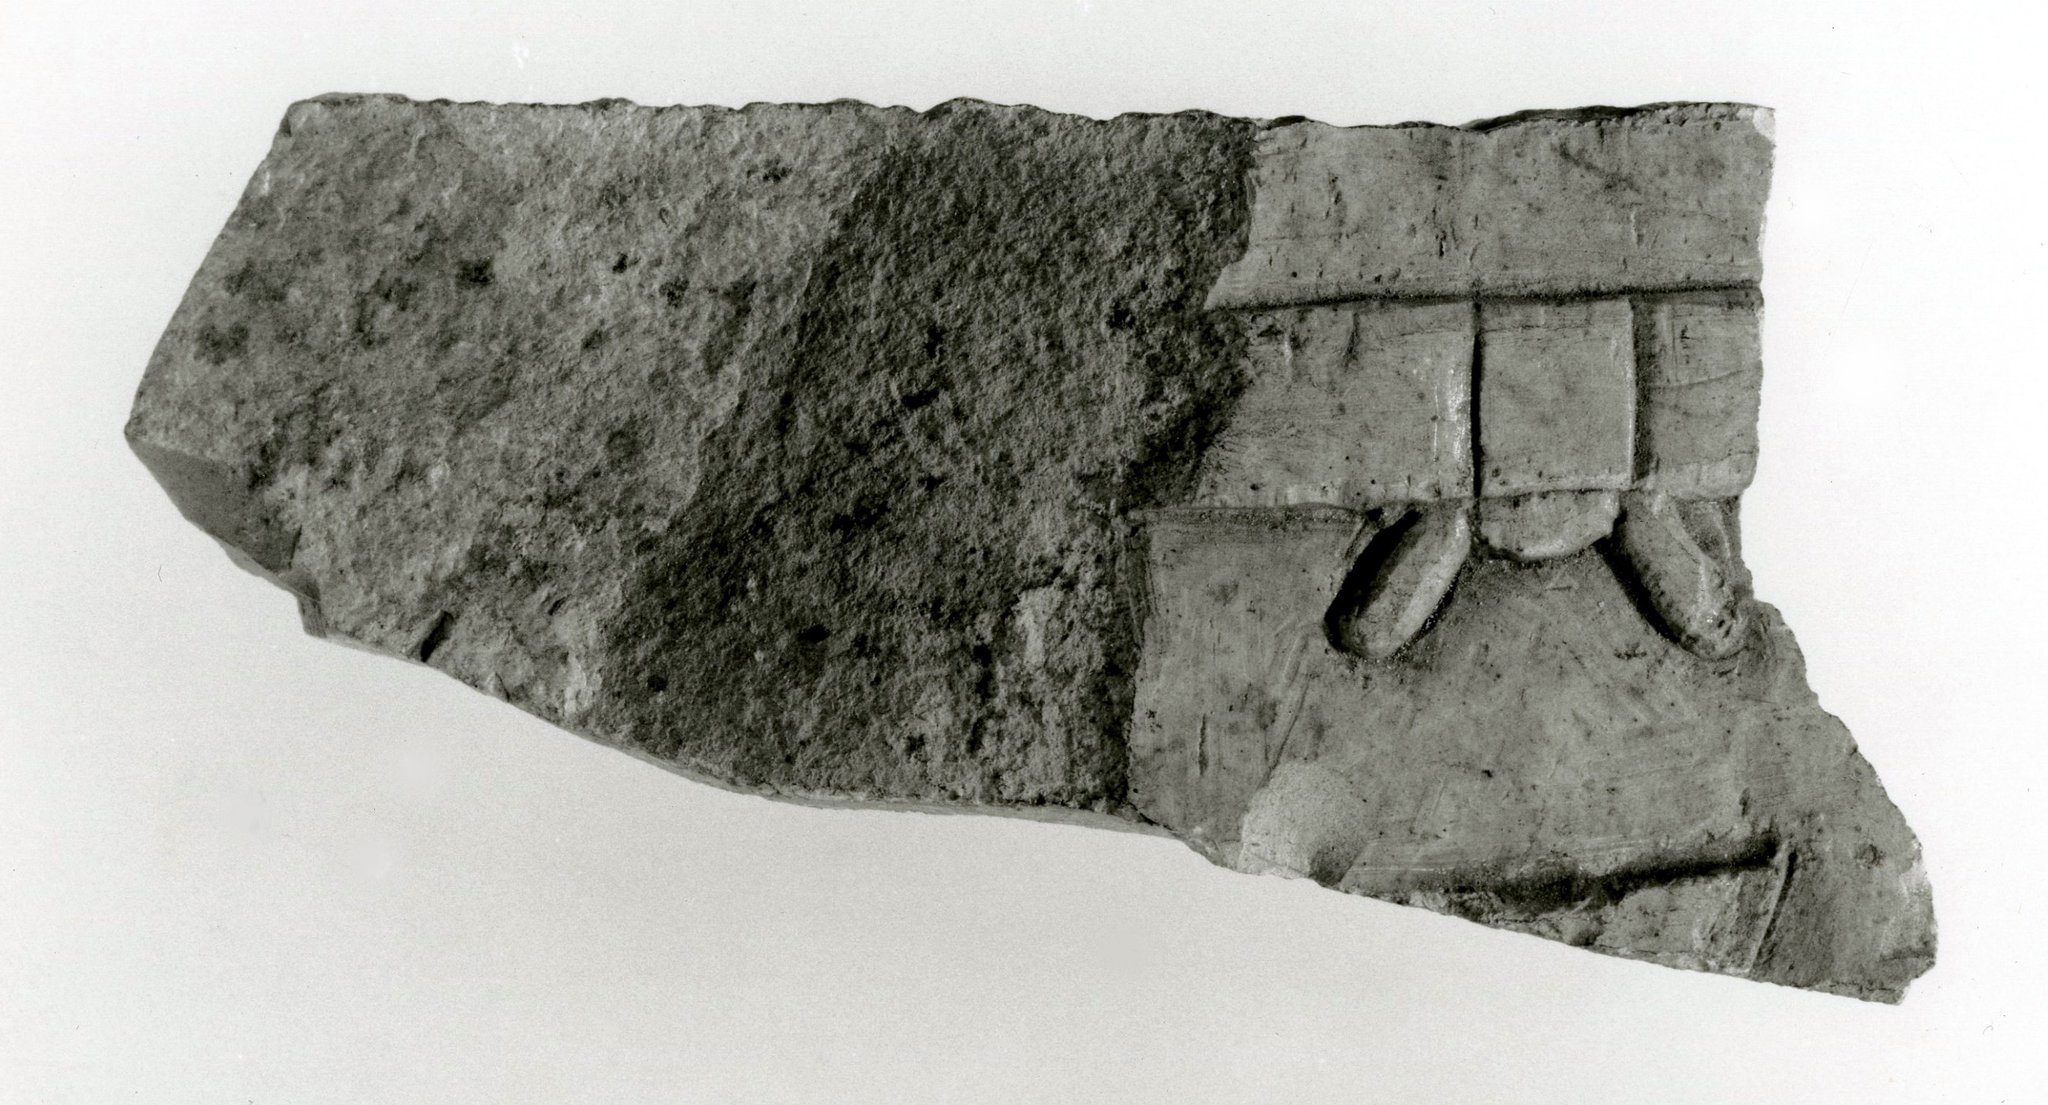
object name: relief, tomb of nespekashuty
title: Raised relief fragment with hieroglyphs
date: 664-610 BCE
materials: limestone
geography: egypt